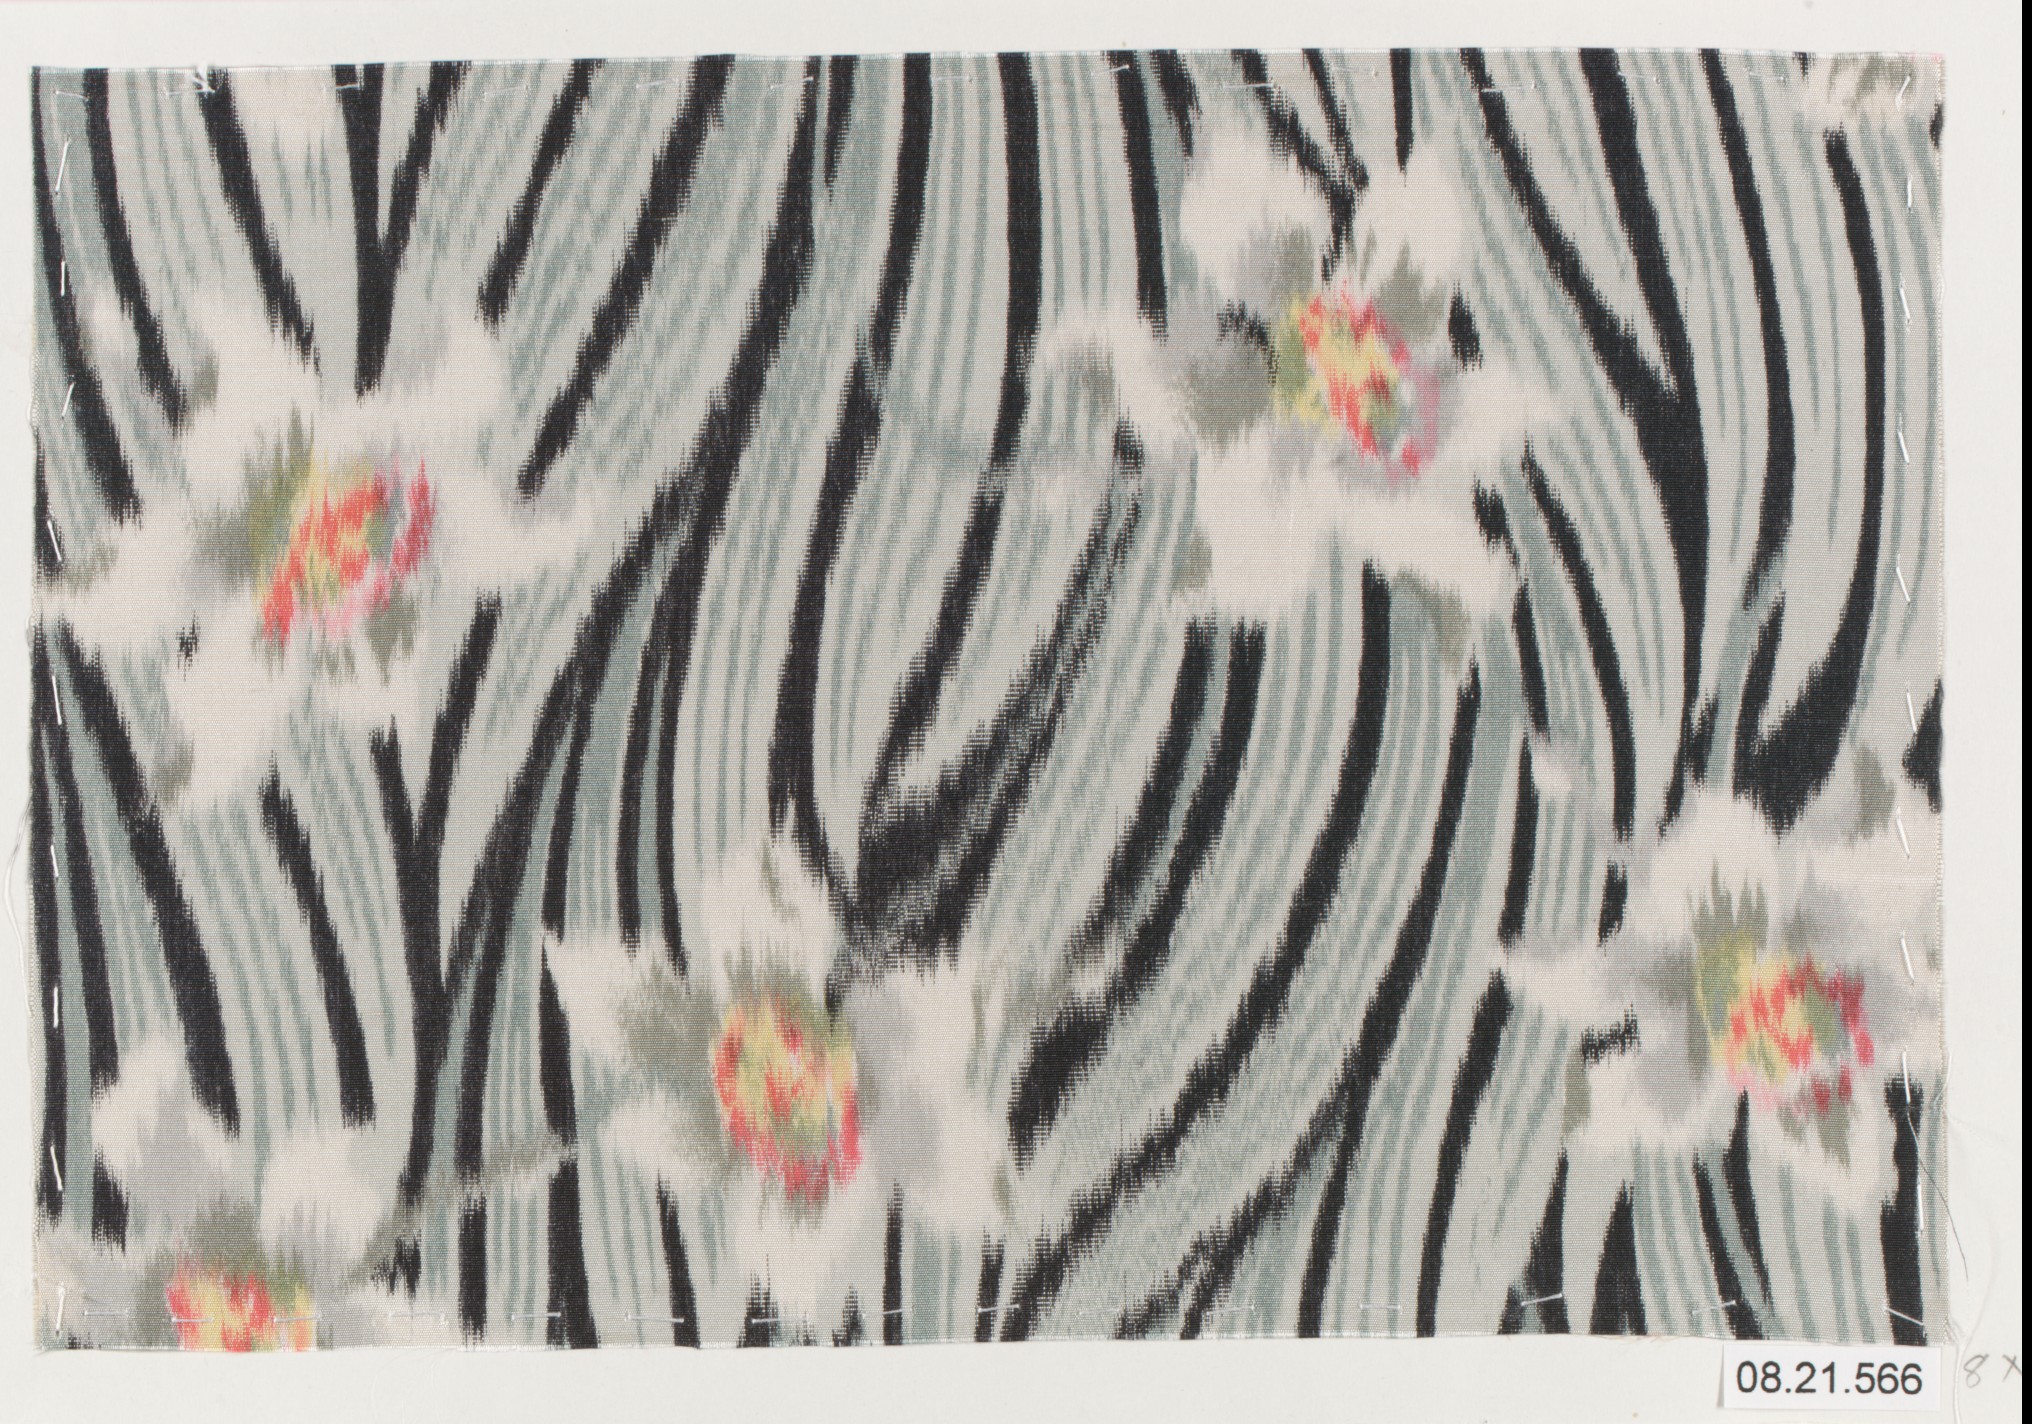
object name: textile sample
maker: Anonymous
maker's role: designer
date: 1900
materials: silk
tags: flowers